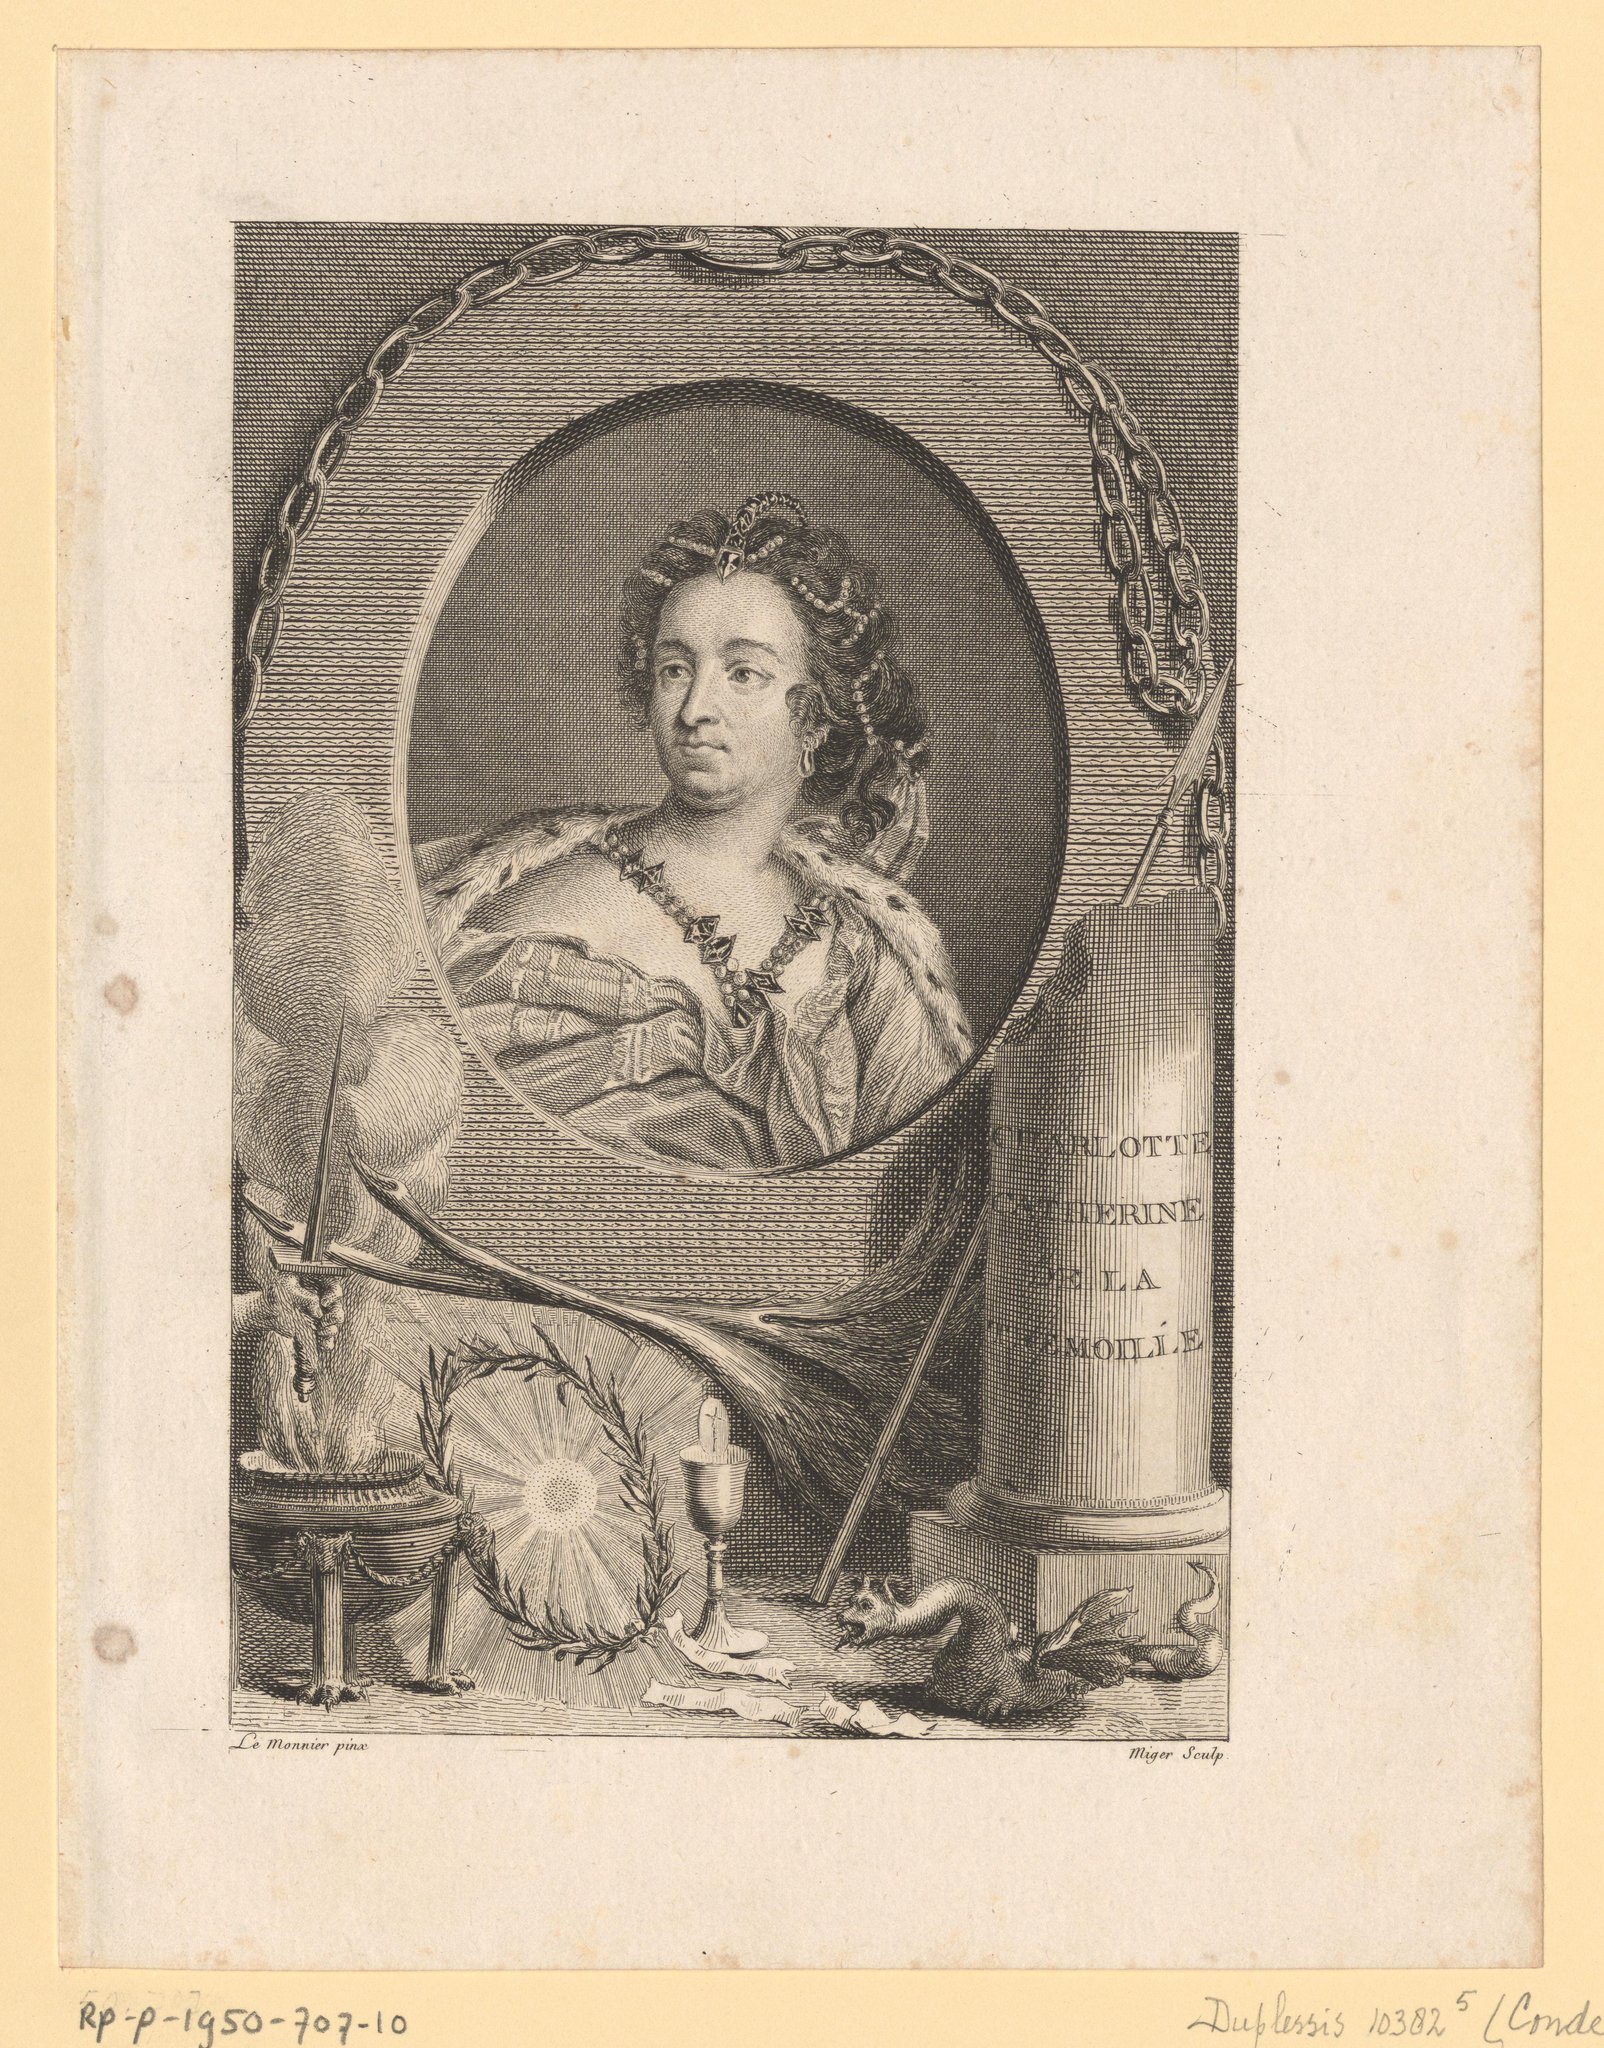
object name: book illustration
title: Portret van Charlotte Catherine de La Trémoille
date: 1788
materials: paper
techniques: engraving, etching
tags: column, pillar ~ architecture, historical persons - bb - woman, chalice, ornament ~ medallion, hacking and thrusting weapons: sword, dragon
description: Prent waarschijnlijk uit: Desormeaux, Joseph-Louis-Ripault. Histoire de la Maison de Bourbon. Parijs: Imprimerie Royale, 1788, dl. 5.